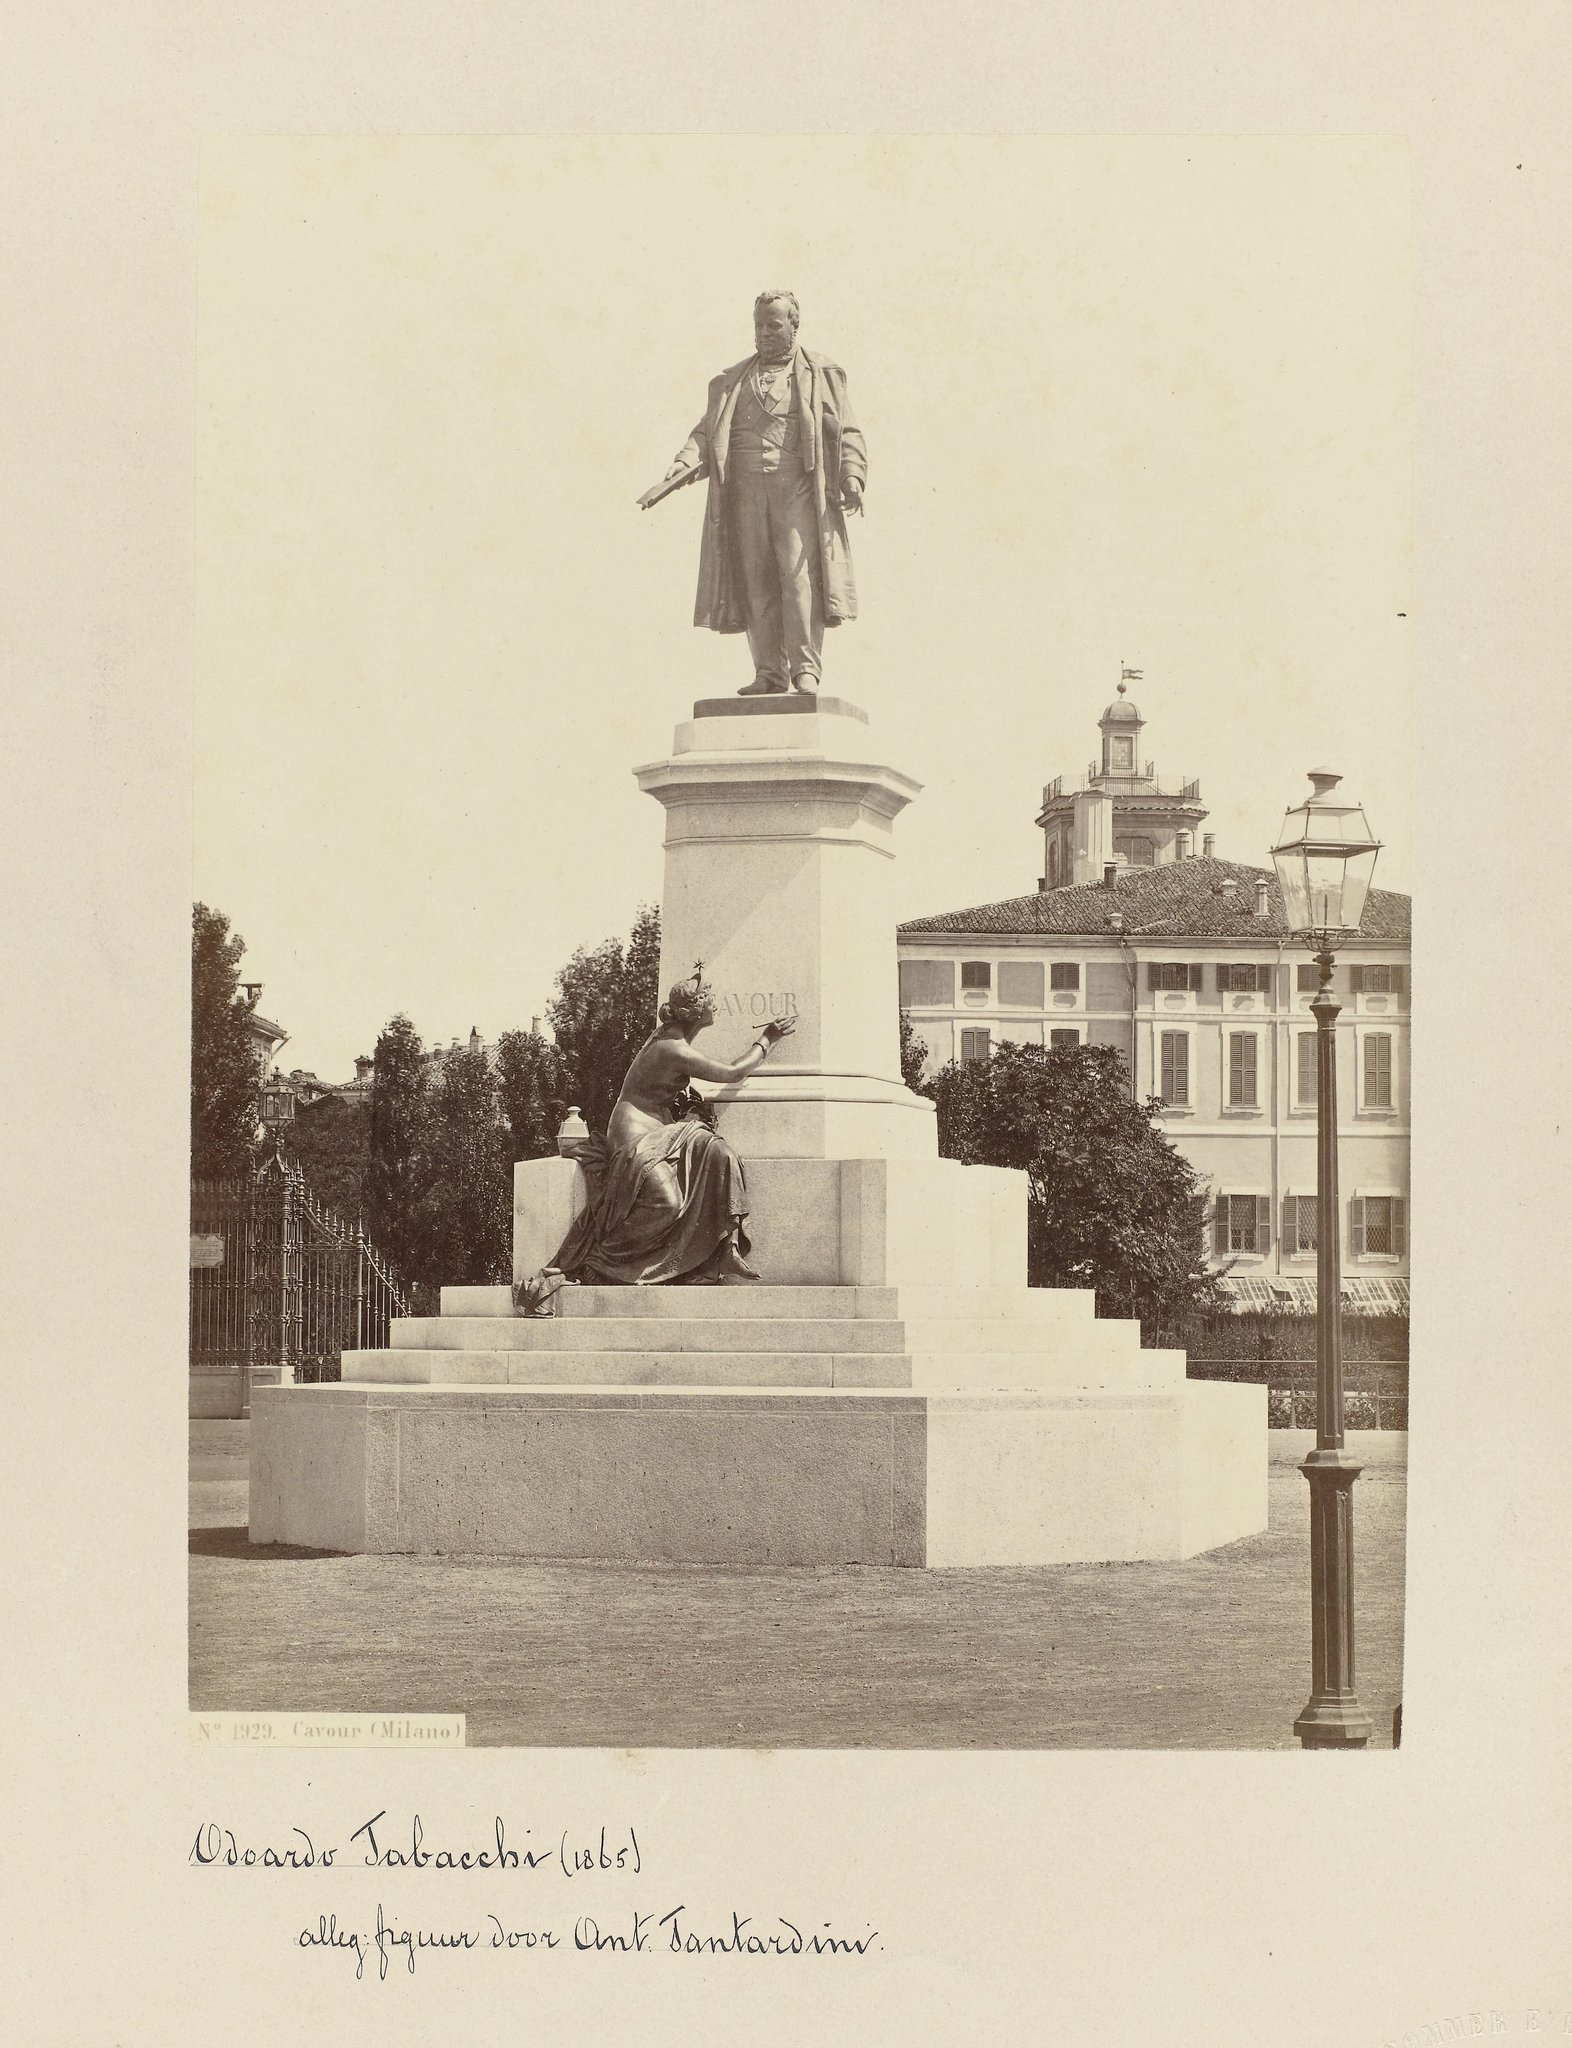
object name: photograph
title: Standbeeld van Cavour op de Piazza Cavour in Milaan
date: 1870-1890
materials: cardboard, paper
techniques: albumen print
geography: naples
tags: politician, monument, statue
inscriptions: check stamp: ‘Sommer e Behles Napoli Monte di Dio 4’, annotation: ‘Odoardo Tabacchi (1865) alleg. figuur door Ant. Tantardini’